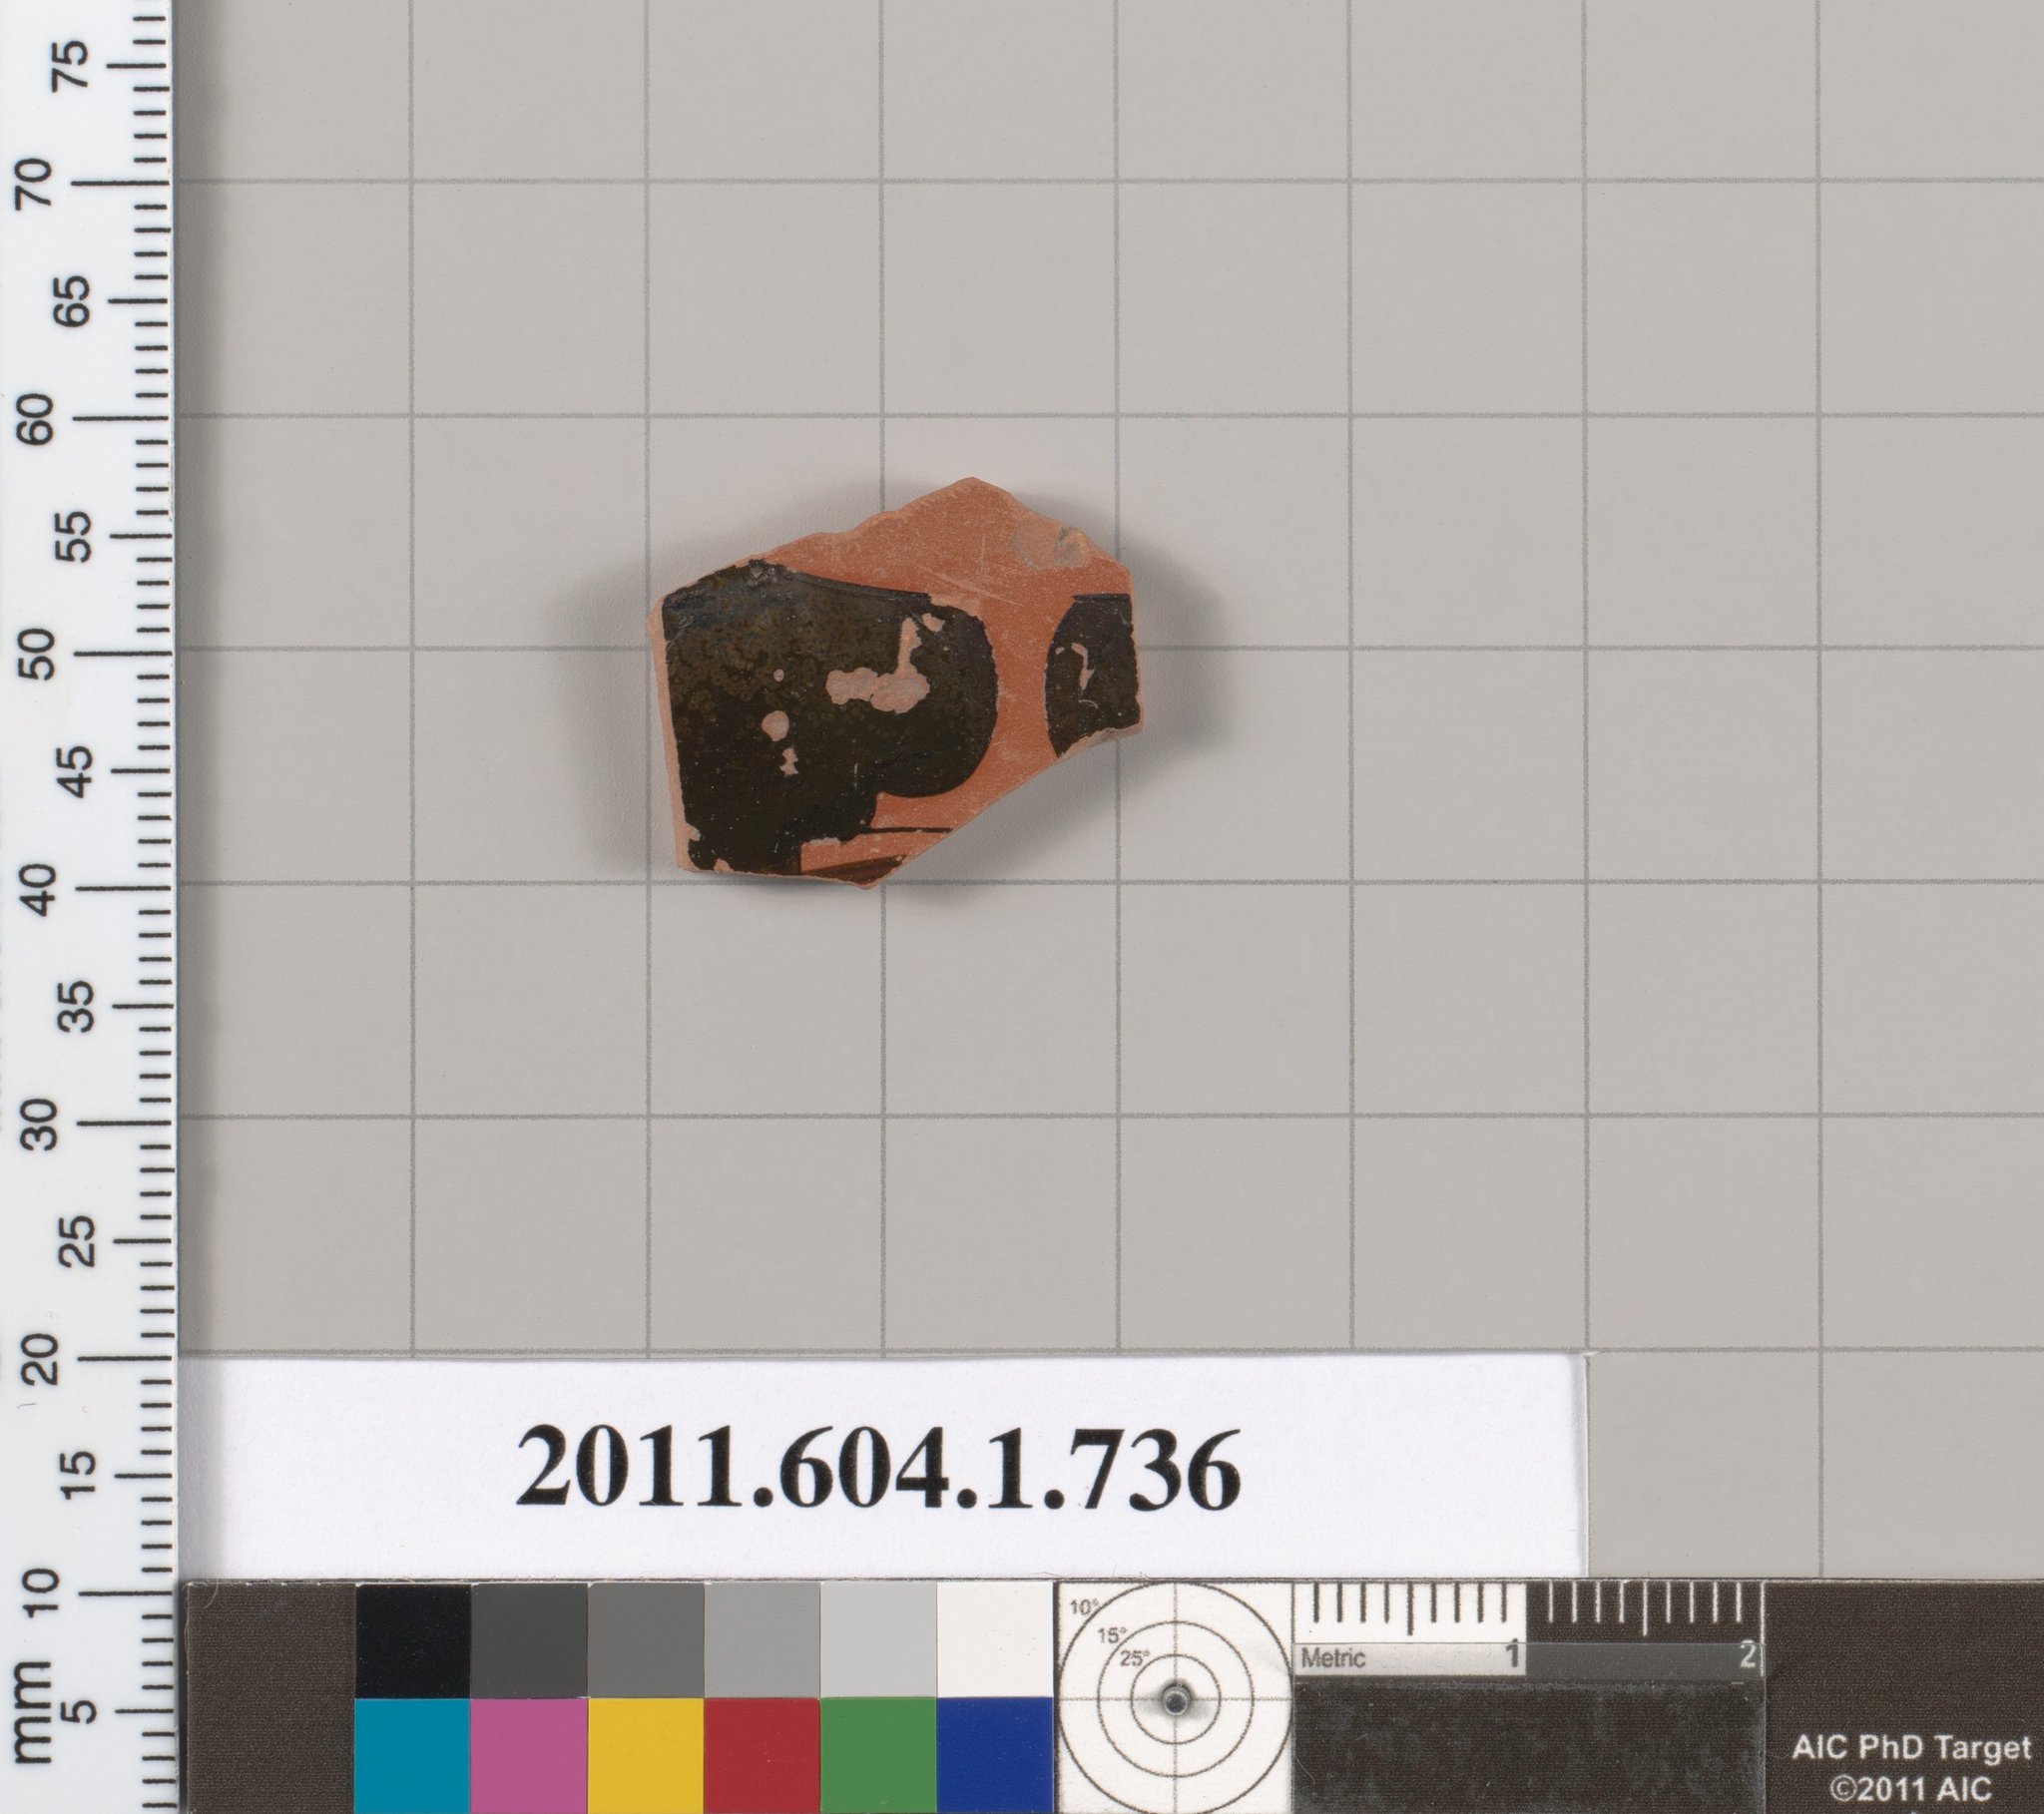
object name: kylix fragment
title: Terracotta fragment of a kylix (drinking cup)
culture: greek, attic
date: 475-451 BCE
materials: terracotta